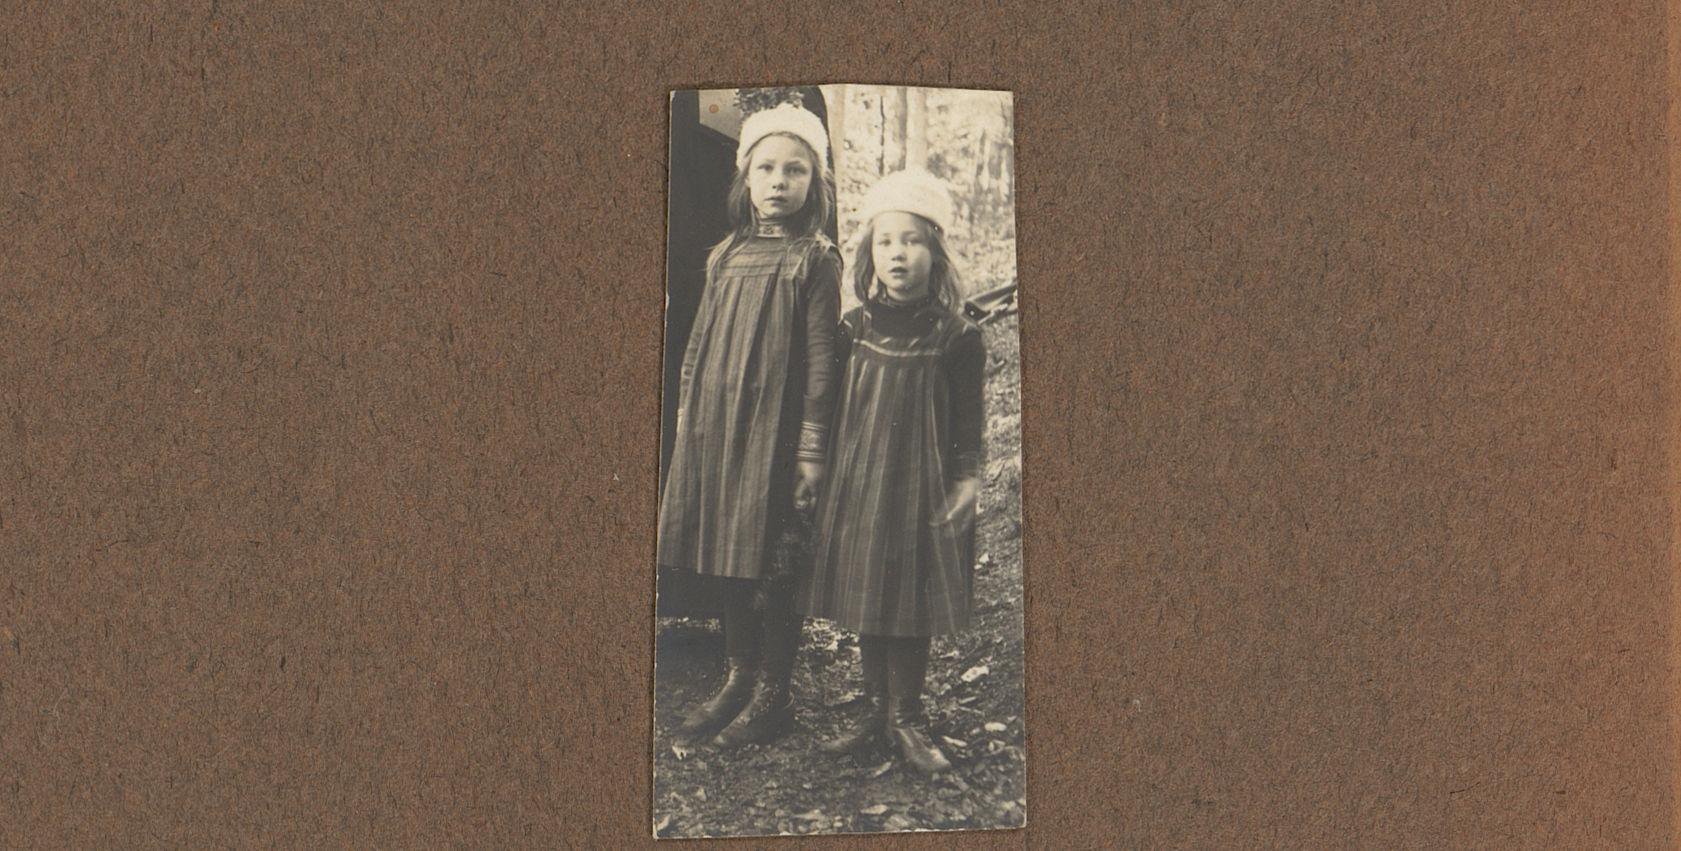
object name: photograph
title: De dochters van Alphons Diepenbrock: Joanna en Thea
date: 1908-1915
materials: photographic support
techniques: photography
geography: netherlands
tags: amsterdam, netherlands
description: Foto op bruin albumblad 45 van familiealbum van Alphons Diepenbrock.